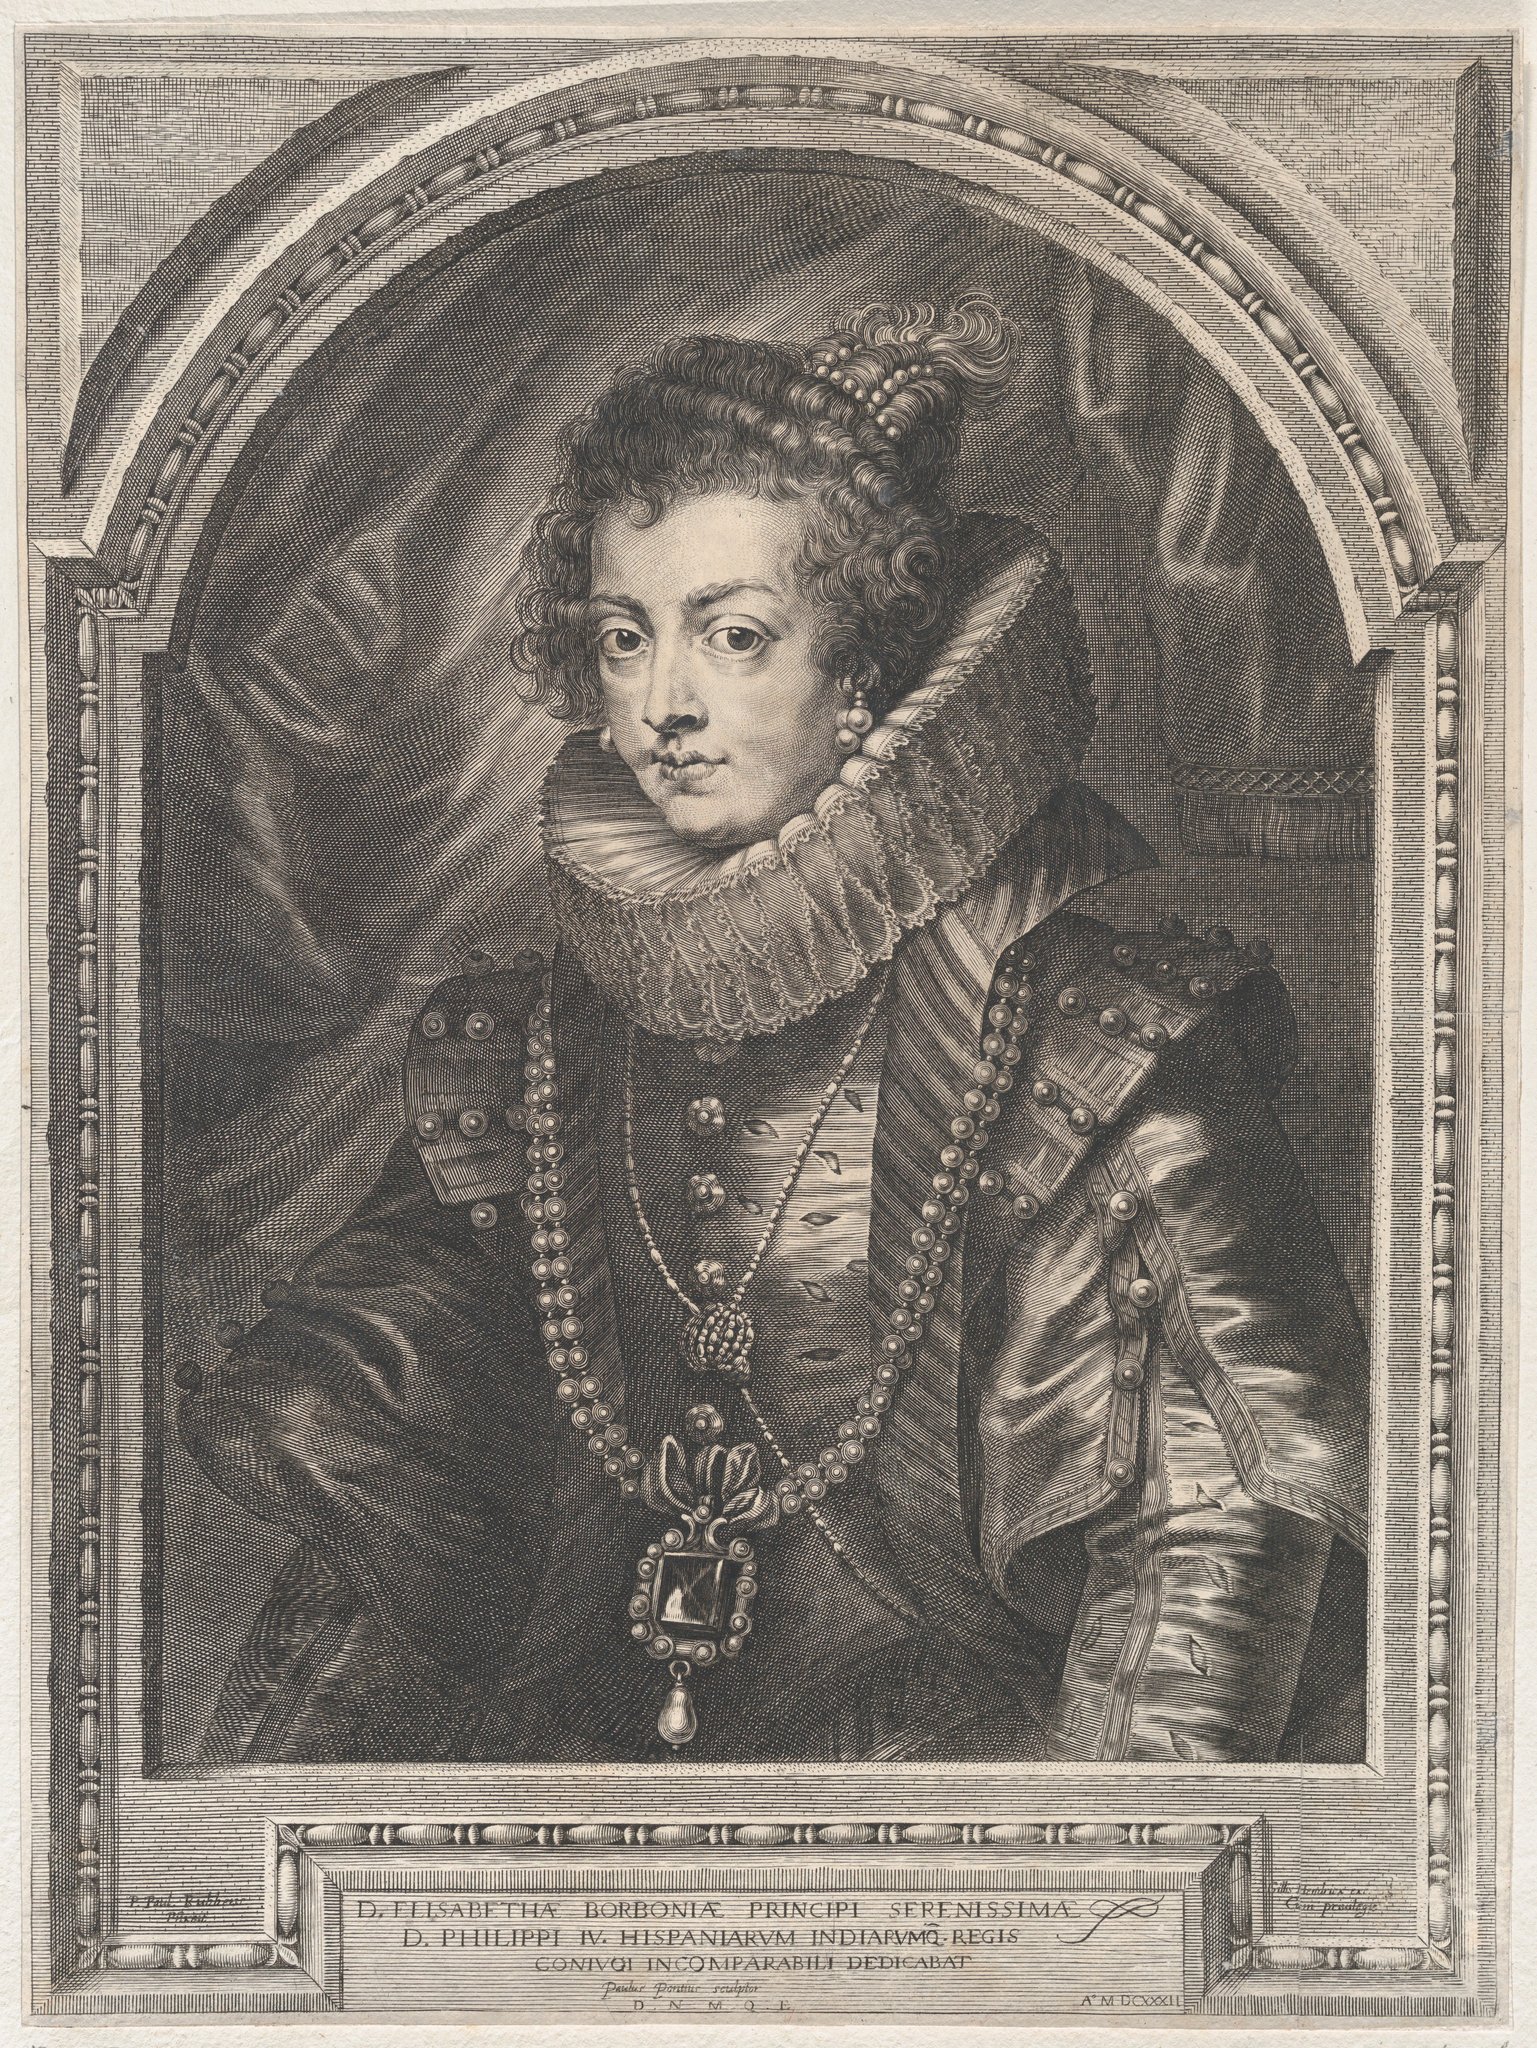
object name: print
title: Portrait of Elisabeth of Bourbon, Queen of Spain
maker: paulus pontius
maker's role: artist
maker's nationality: flemish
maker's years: 1603-1658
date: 1632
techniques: engraving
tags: queens,portraits,women